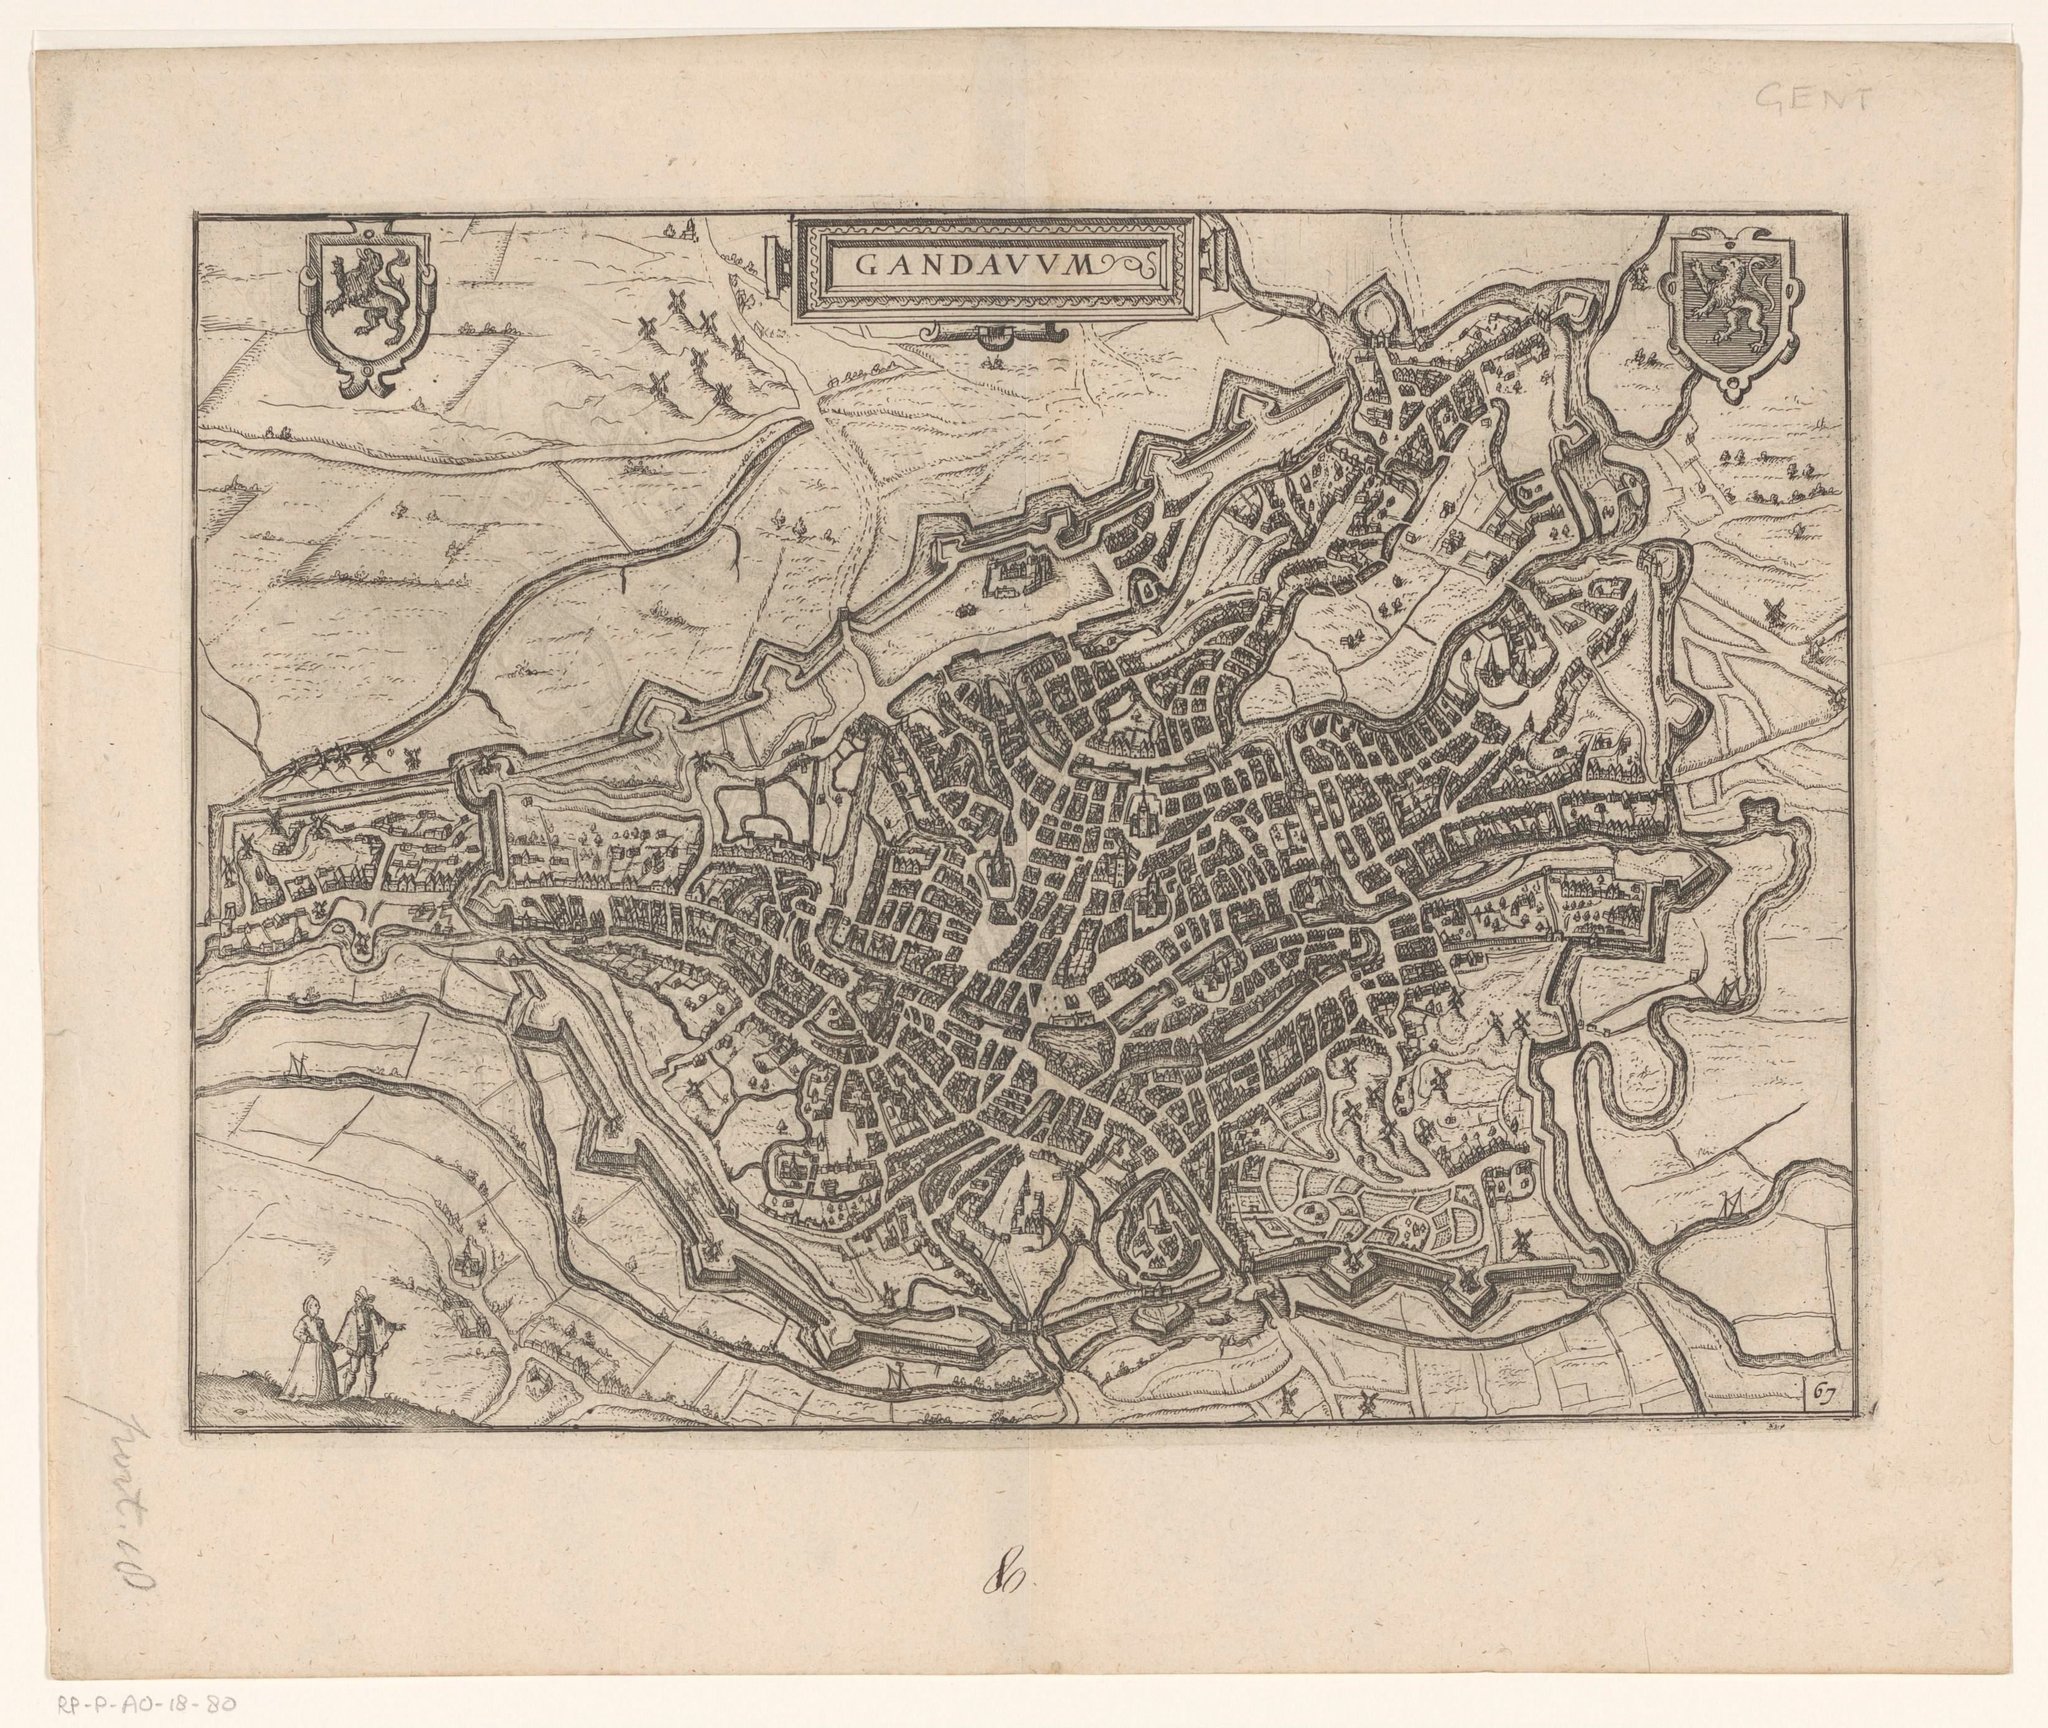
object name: area plan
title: Gandavum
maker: Anonymous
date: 1612-1648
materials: paper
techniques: engraving, etching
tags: coat of arms (as symbol of the state, etc.) (+ city; municipal), maps of cities, coat of arms (as symbol of the state, etc.) (+ province; provincial), ghent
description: Deze staat van prent voor het eerst ook gebruikt in: Guicciardini, Lodovico. Beschryvinghe van alle de Neder-landen, anderssins ghenoemt Neder-Duytslandt (…). Amsterdam: Willem Janszoon Blaeu, 1612. Hierna is deze prent tot 1648 nog gebruikt in latere uitgaven van deze publicatie, uitgegeven door Blaeu en daarna door Janssonius. Uit welke uitgave het huidige exemplaar precies komt is niet na te gaan.